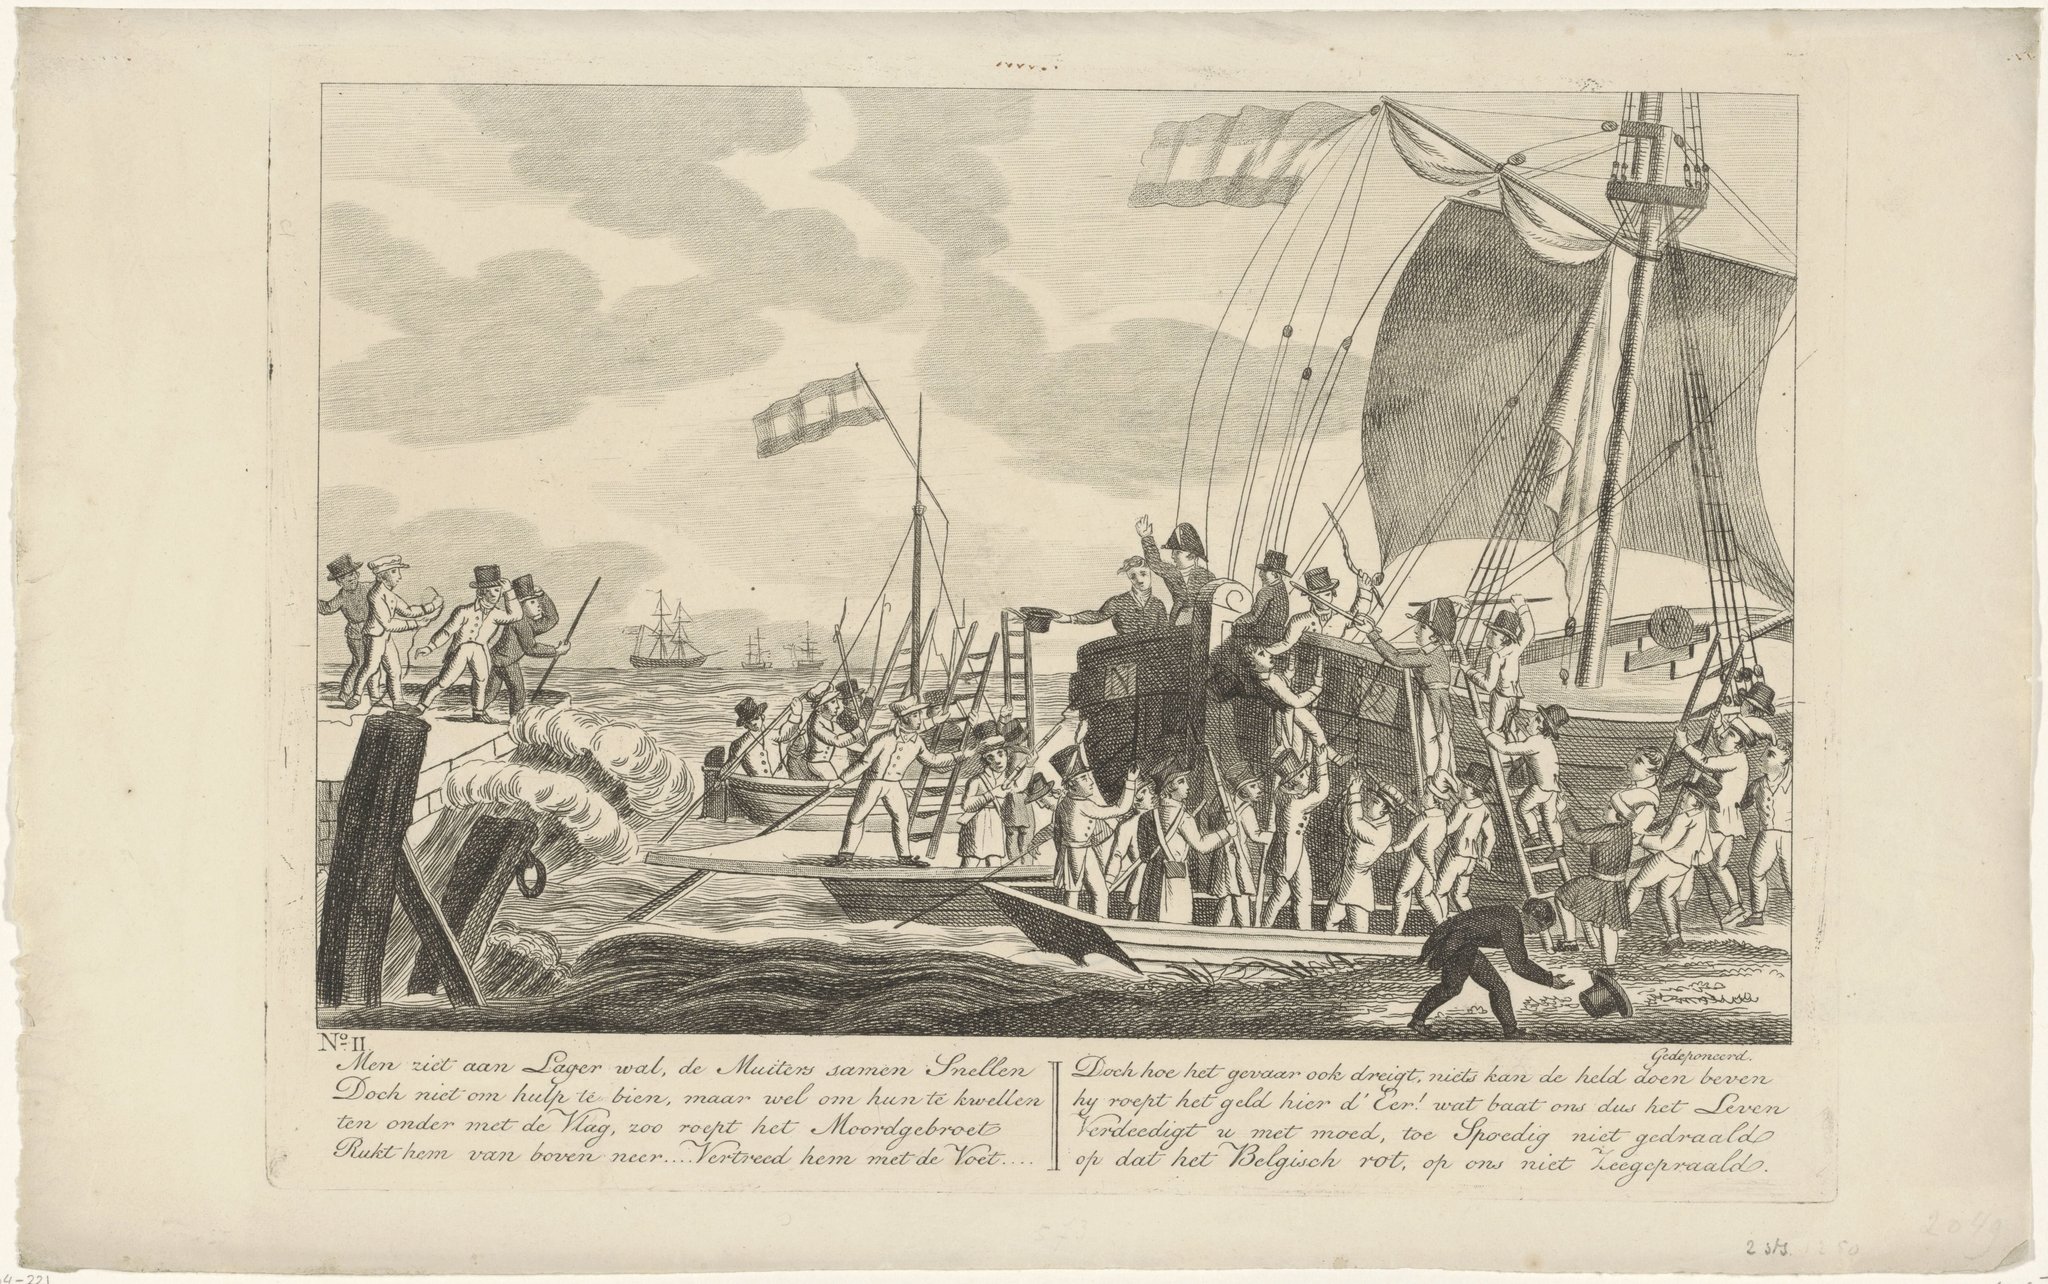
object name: print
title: Vier episoden uit de geschiedenis van Jan van Speyk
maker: Anonymous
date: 1831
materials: paper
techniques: engraving, etching, roulette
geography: netherlands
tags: amsterdam, antwerp, jan van speyk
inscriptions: collector's mark: Lugt 2228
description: De kanonneerboot van Jan van Speyk overrompeld door de Belgen, 5 februari 1831. Vanaf schuiten klimmen de Belgen aan boord van het schip. Tweede prent in een serie van vier platen van de geschiedenis van Jan van Speyk. Met twee vierregelige verzen in het onderschrift.